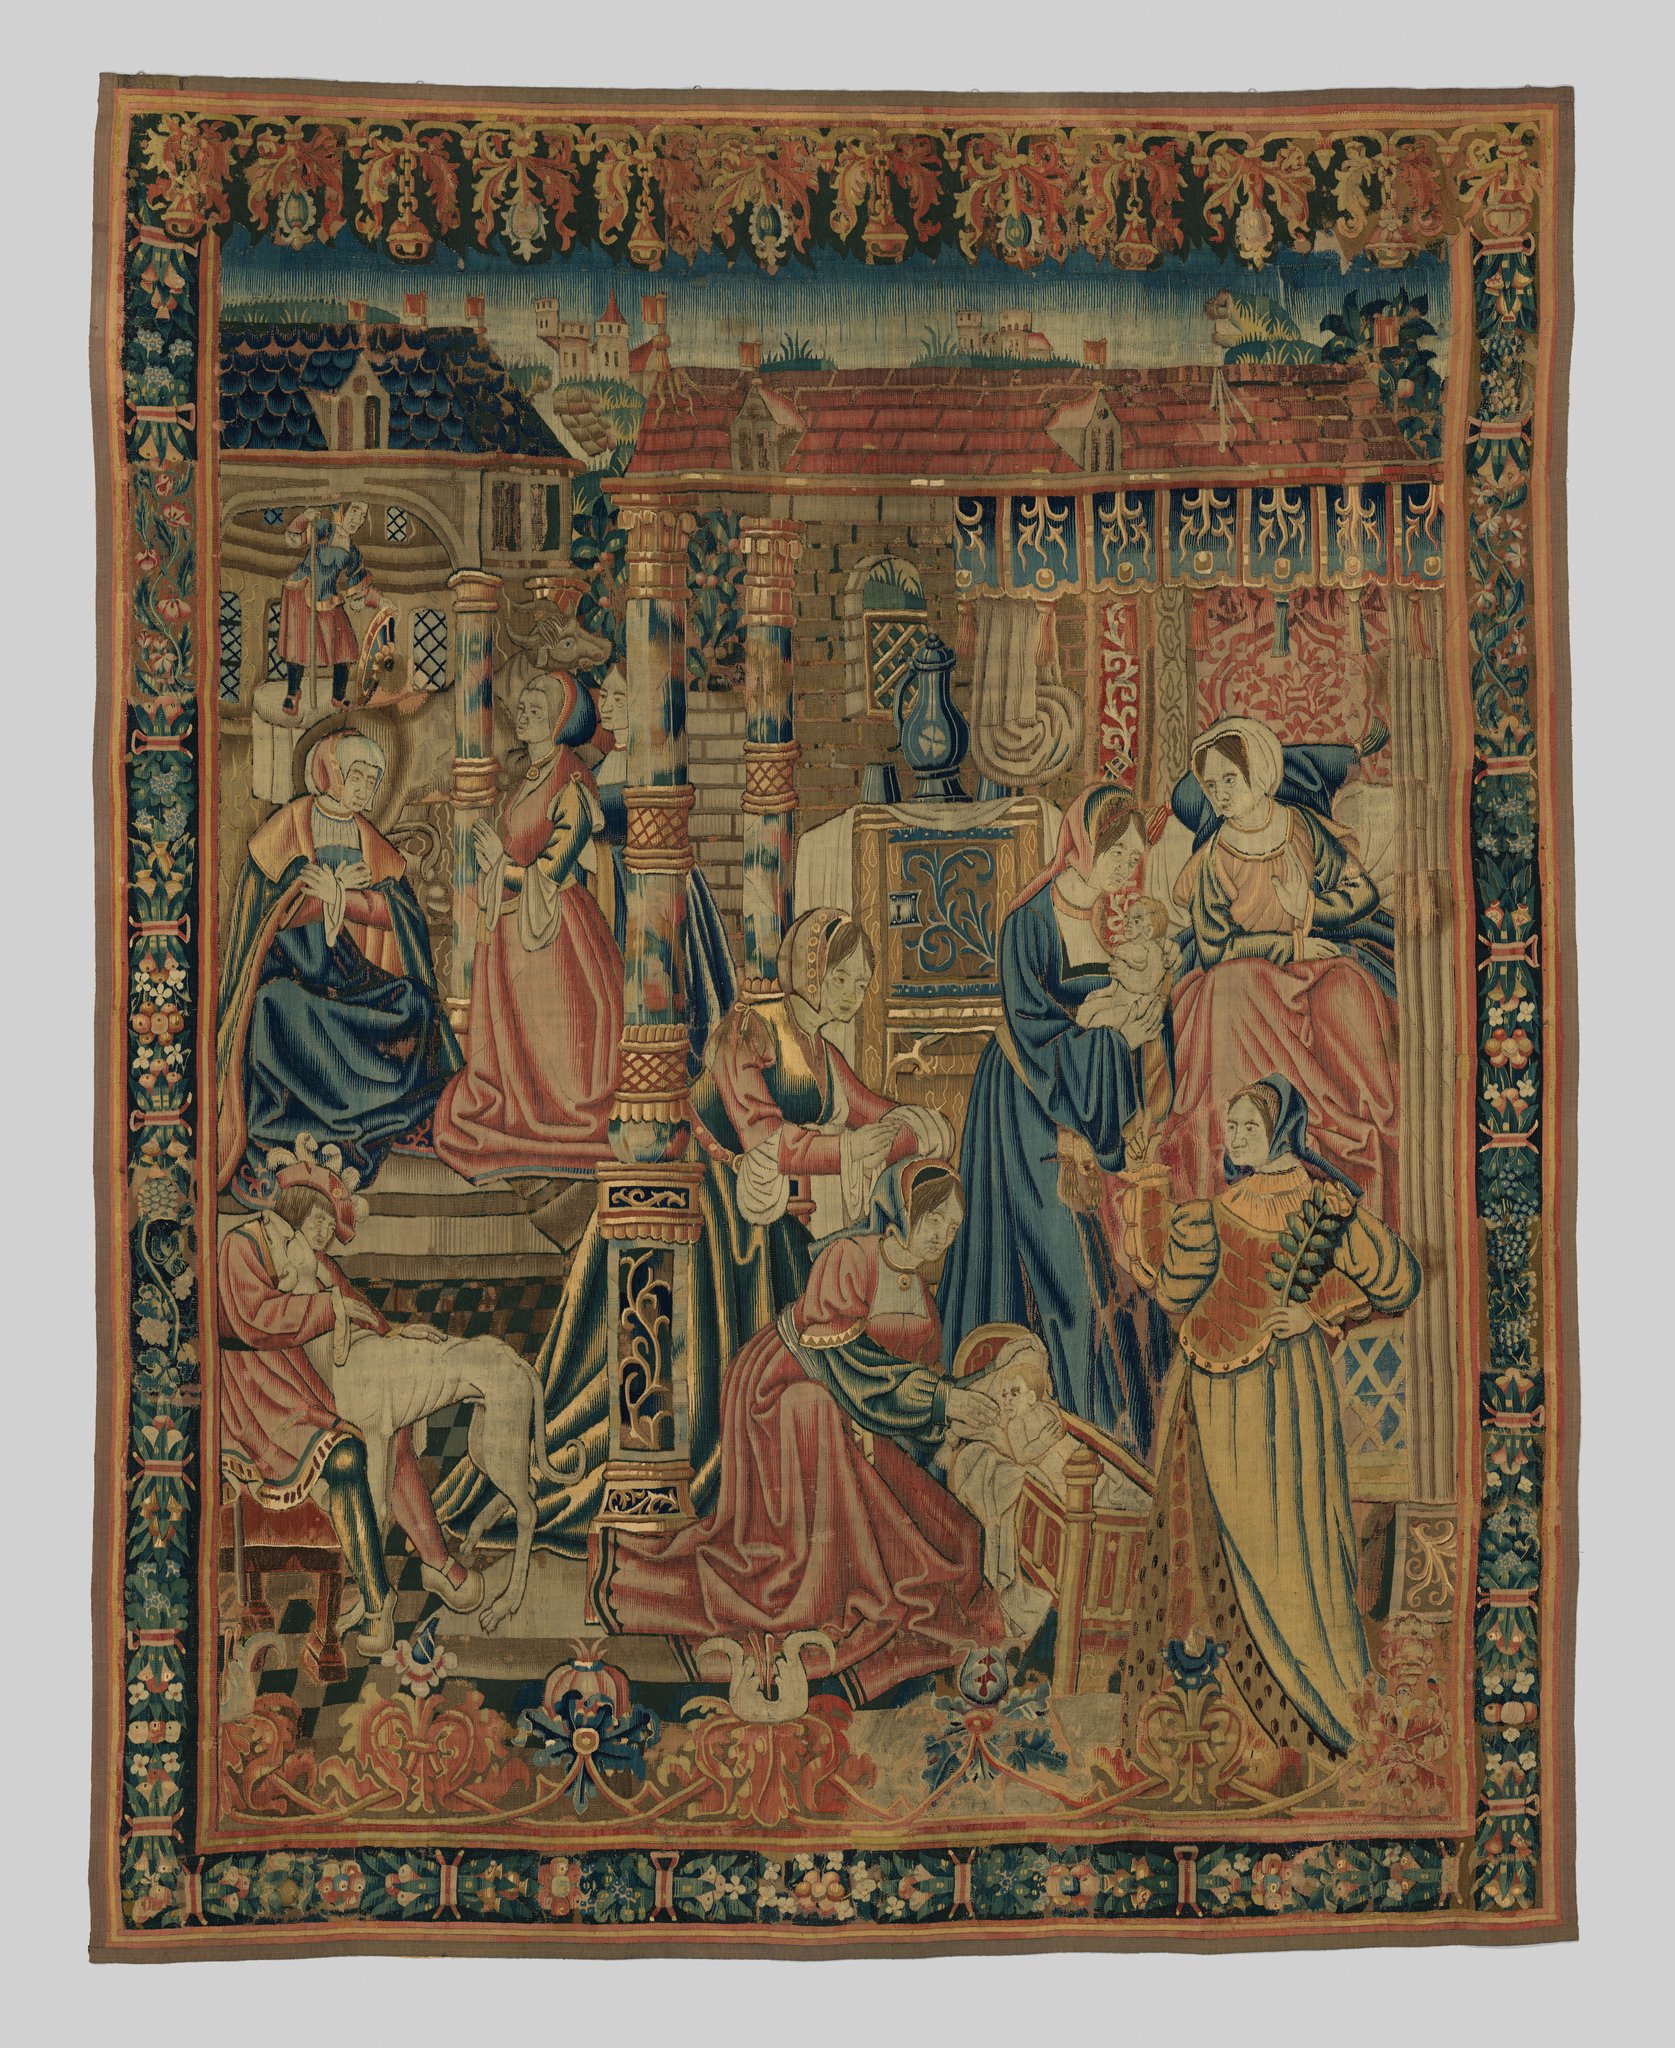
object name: tapestry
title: Four Episodes in the Story of Hercules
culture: south netherlandish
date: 1515-1535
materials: silk, wool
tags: castles,columns,bedrooms,armor,infants,women,hercules,diana,juno,cows,dogs,roses